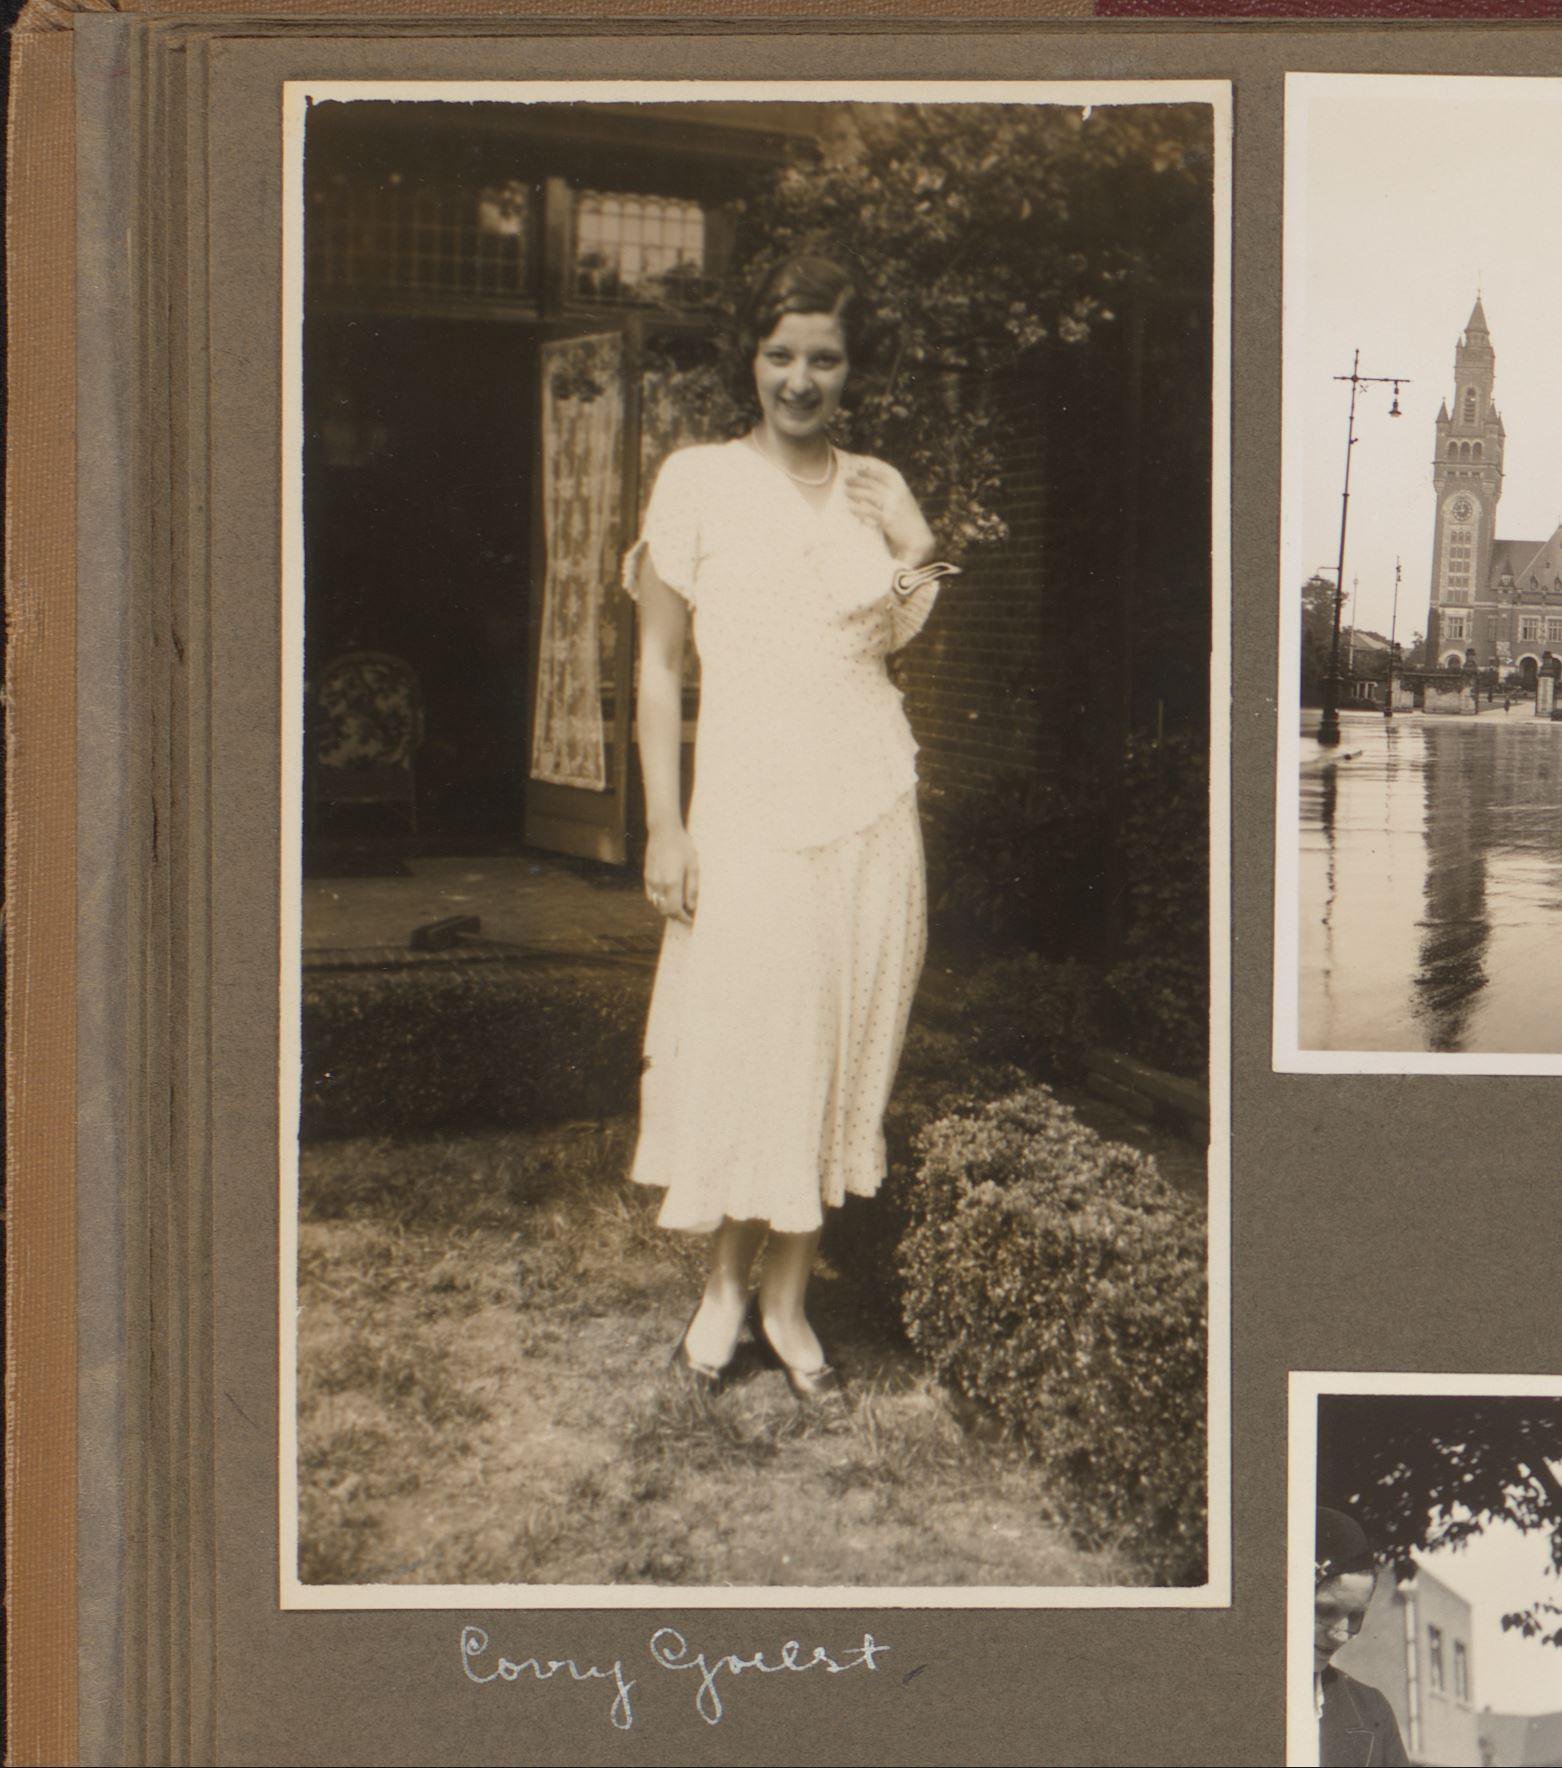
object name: album leaf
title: Portret van Corry Goelst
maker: Anonymous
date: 1932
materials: paper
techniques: gelatin silver print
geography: the hague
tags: historical persons - bb - woman, pavement, terrace in front of inn or restaurant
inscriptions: inscription: ‘Corry Goelst’